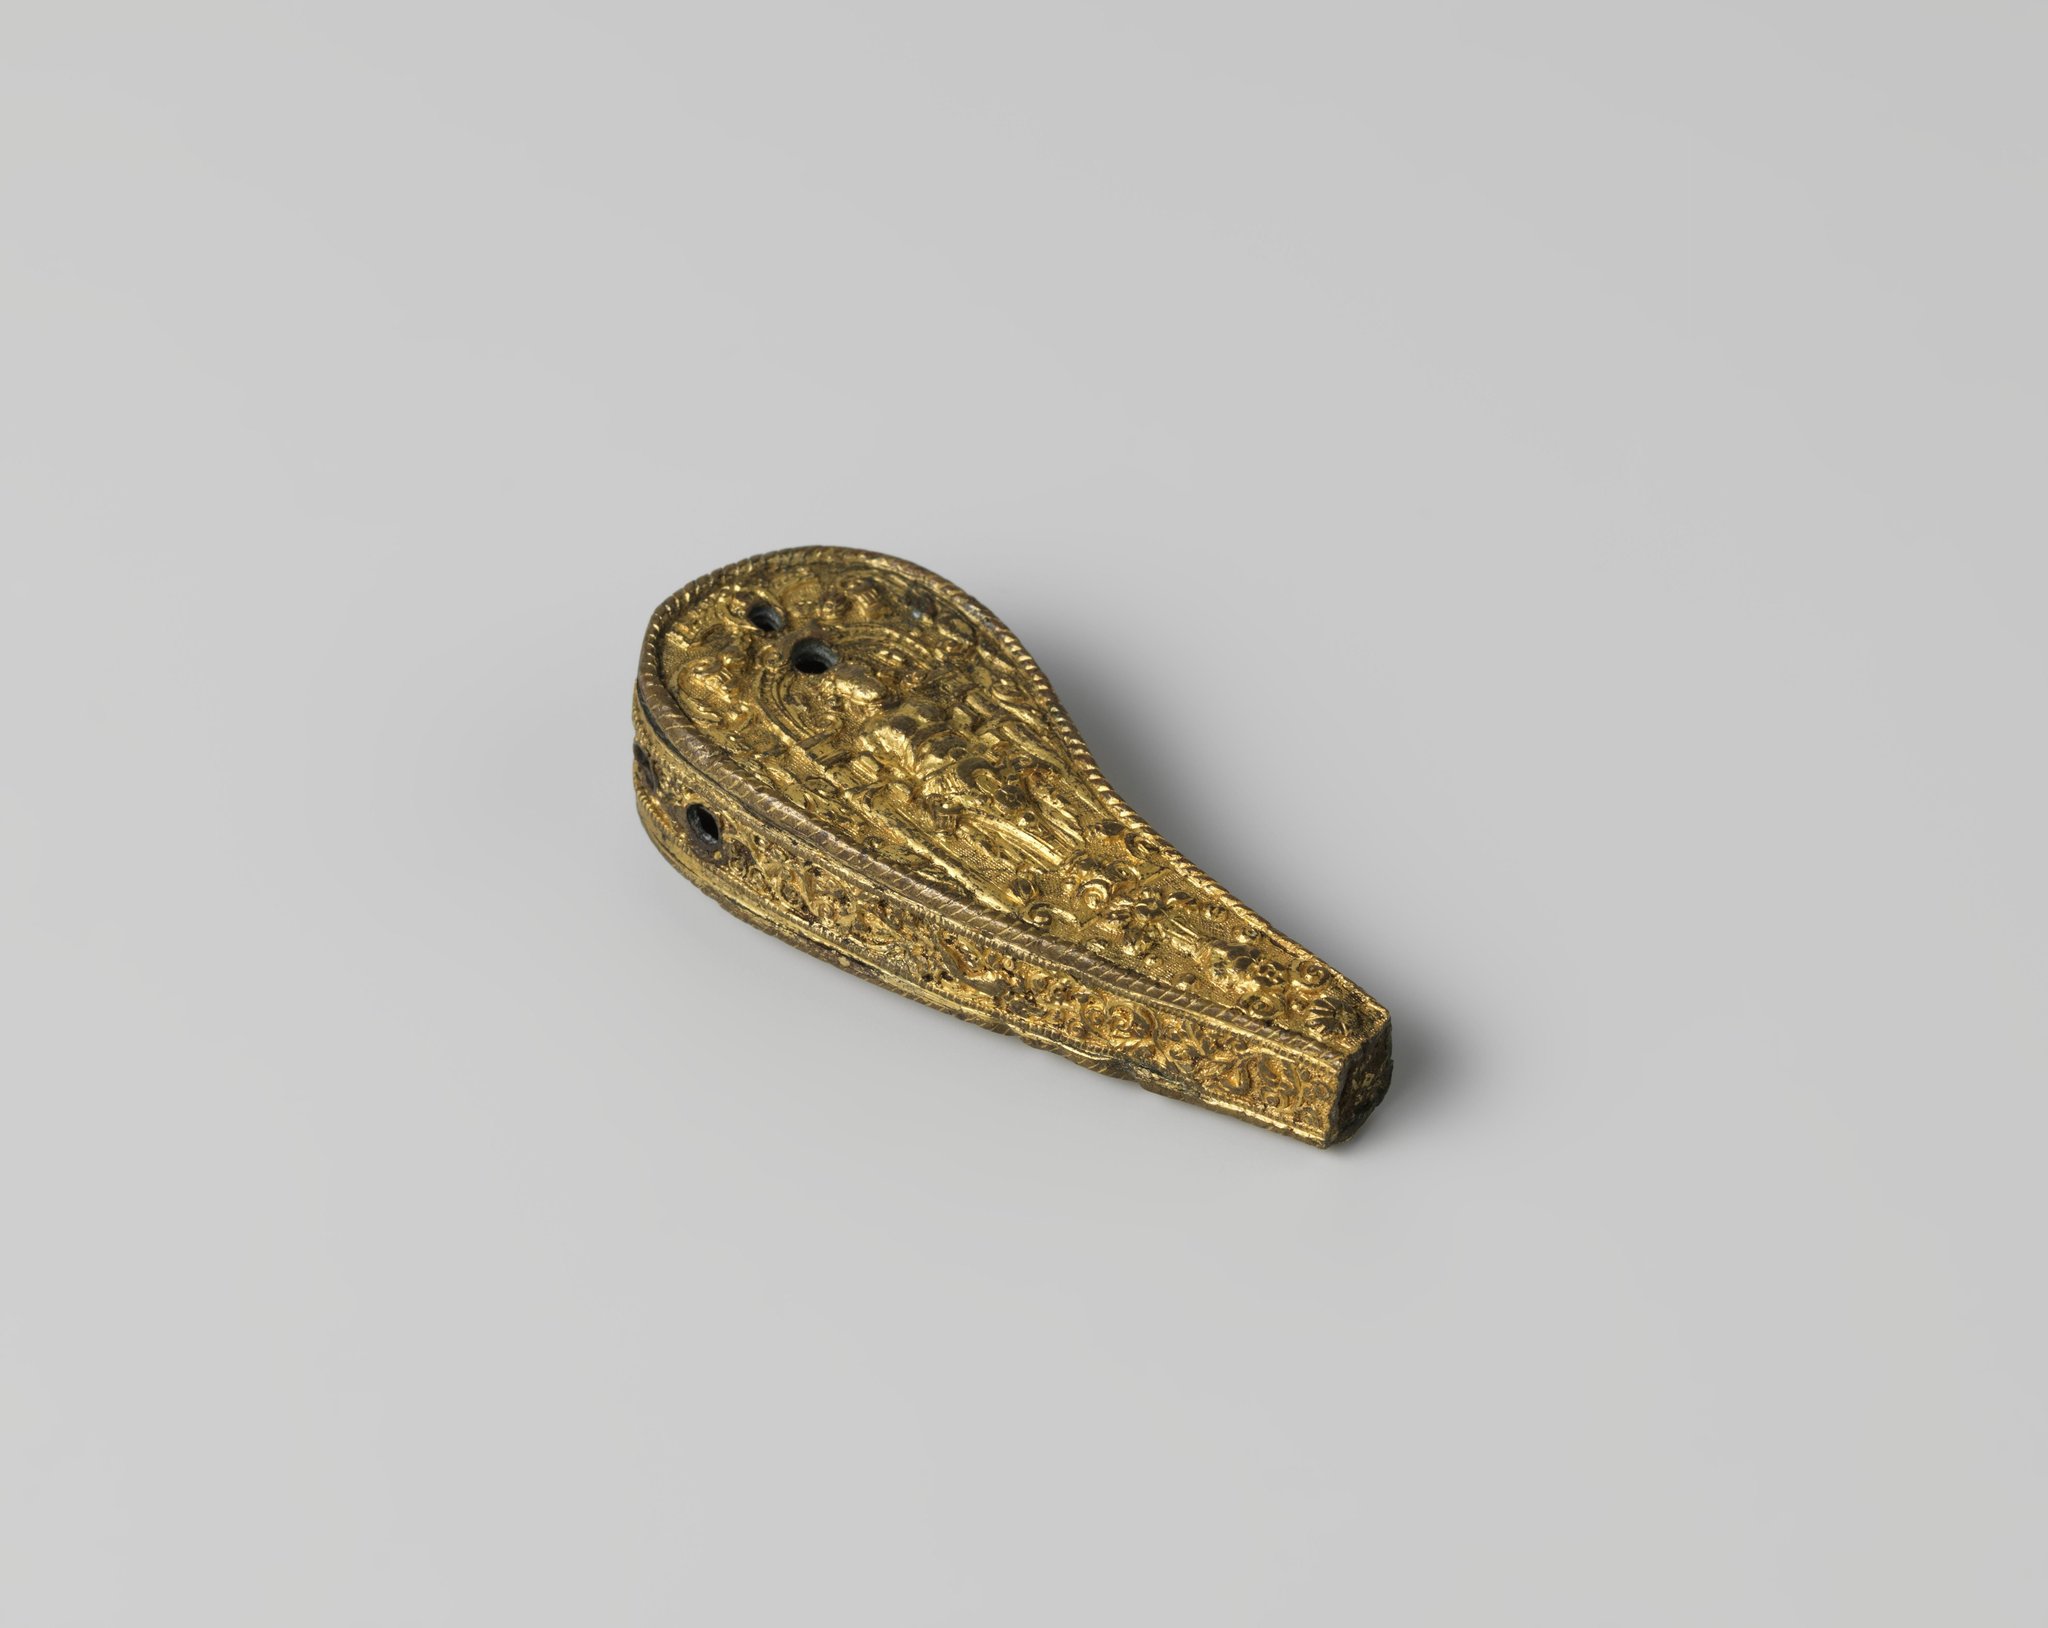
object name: fragment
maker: Anonymous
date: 1550-1600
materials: brass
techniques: casting, gilding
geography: southern netherlands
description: Het gegoten fragment is samengesteld uit vier delen: de twee delen, waarop een herme is weergegeven, het deel dat hen verbindt, en de afgebroken aanzet op het punt, waar deze drie delen samenkomen. Op twee delen, die onderling verschillend zijn geornamenteerd, is een herme opgenomen in rolwerk. Dit is verder versierd met gestileerd bladwerk, vruchten, een op een masker geplaatste korf met vruchten en - aan één kant - een leeuwenmasker. Het derde deel is versierd met rankenwerk, waarin telkens een hond is opgenomen, van welke figuratie er nog maar twee volledig te zien zijn. De overige zijn geheel of gedeeltelijk verdwenen door de twee ronde en de twee vierkante gaten. In één van de twee delen met een herme zijn eveneens twee ronde gaten aangebracht. Het voorwerp is afgebroken.